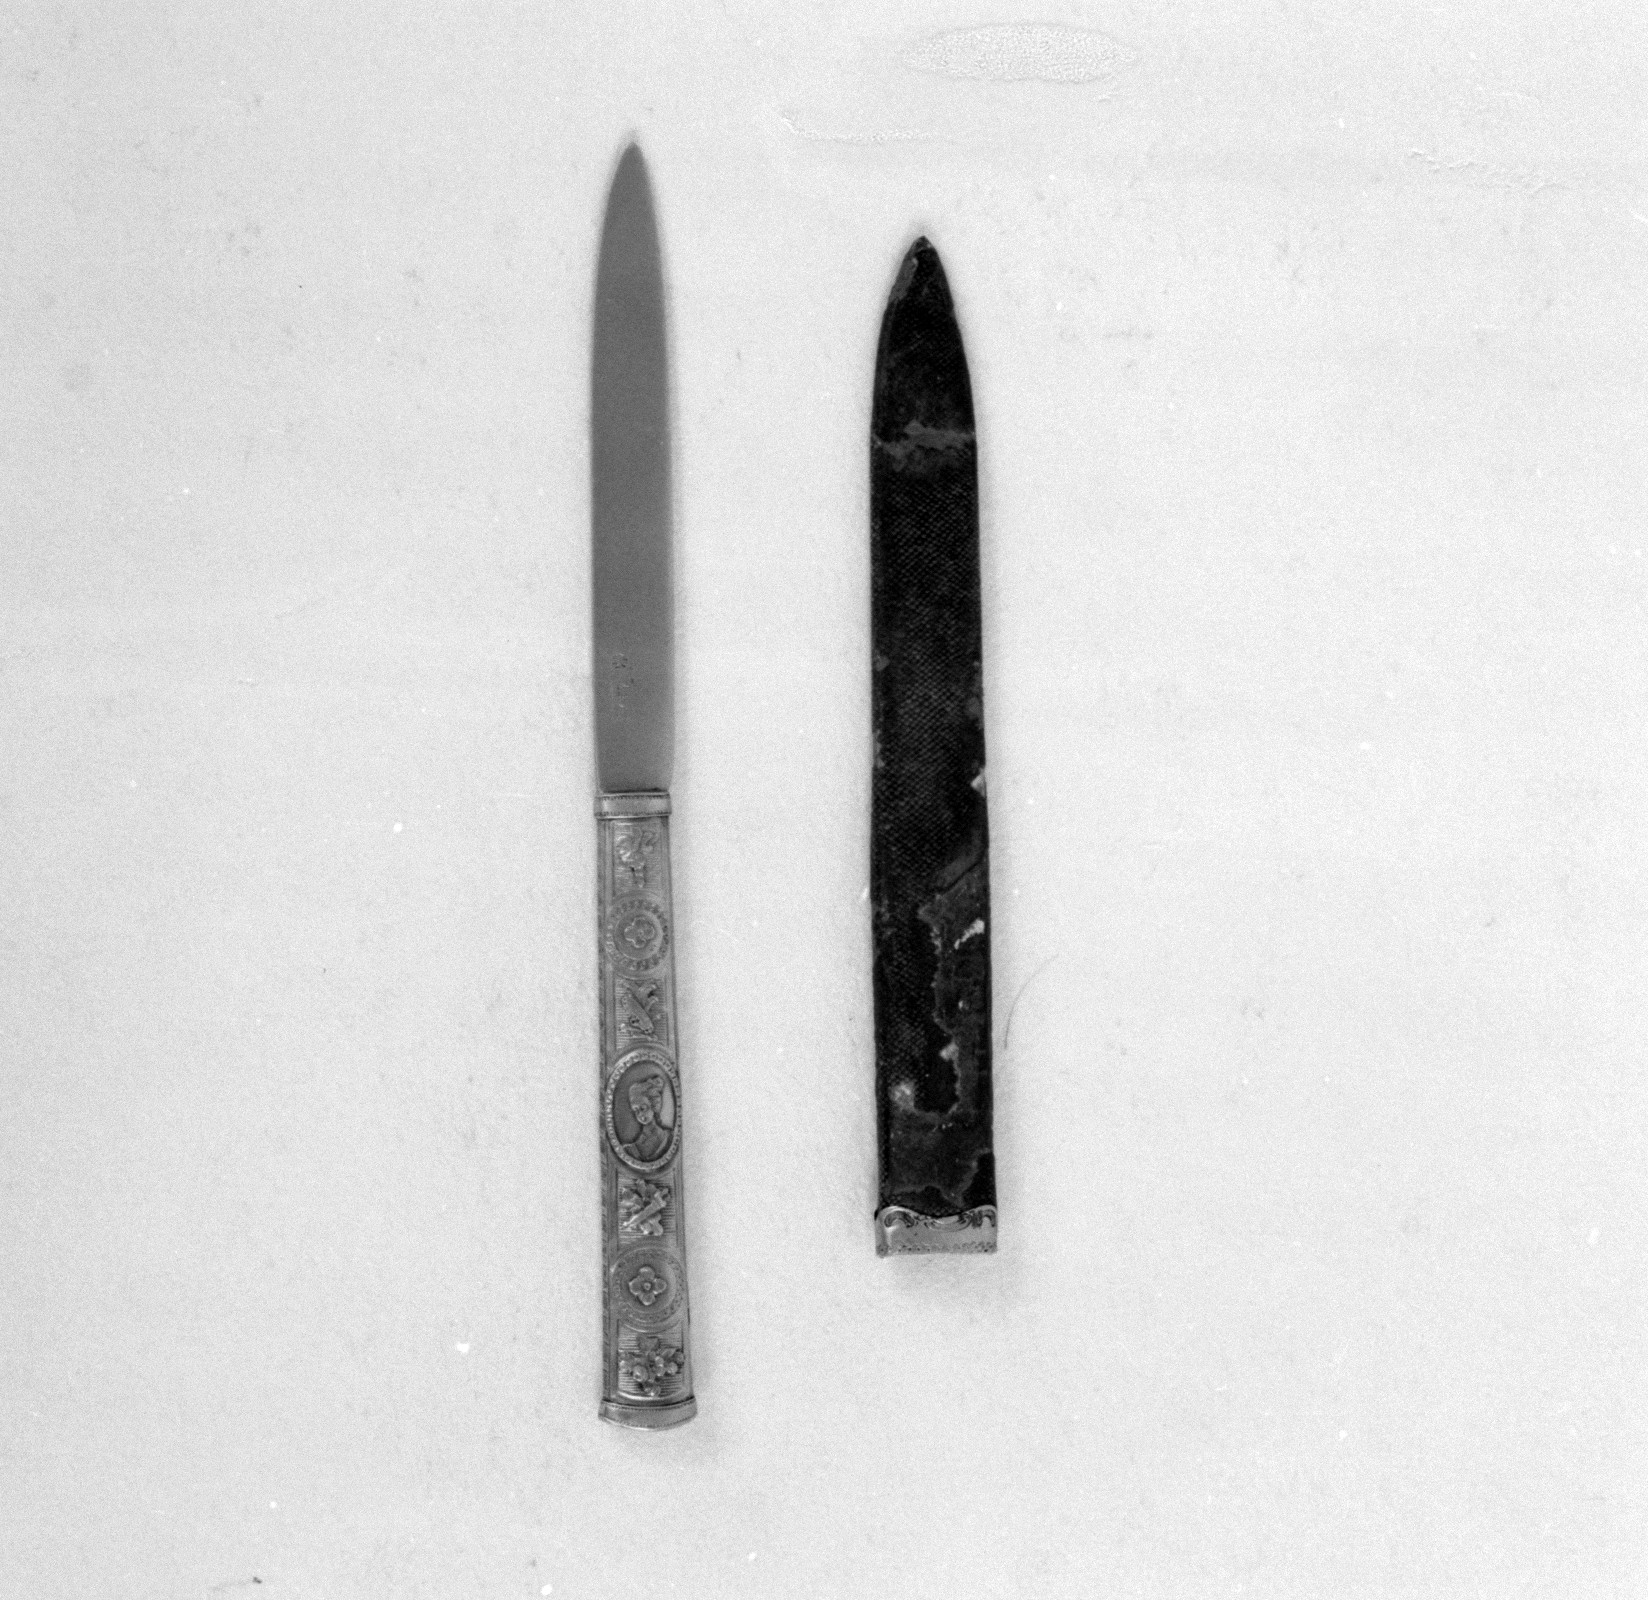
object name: knife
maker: i. g., switzerland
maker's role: maker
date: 1770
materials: gold